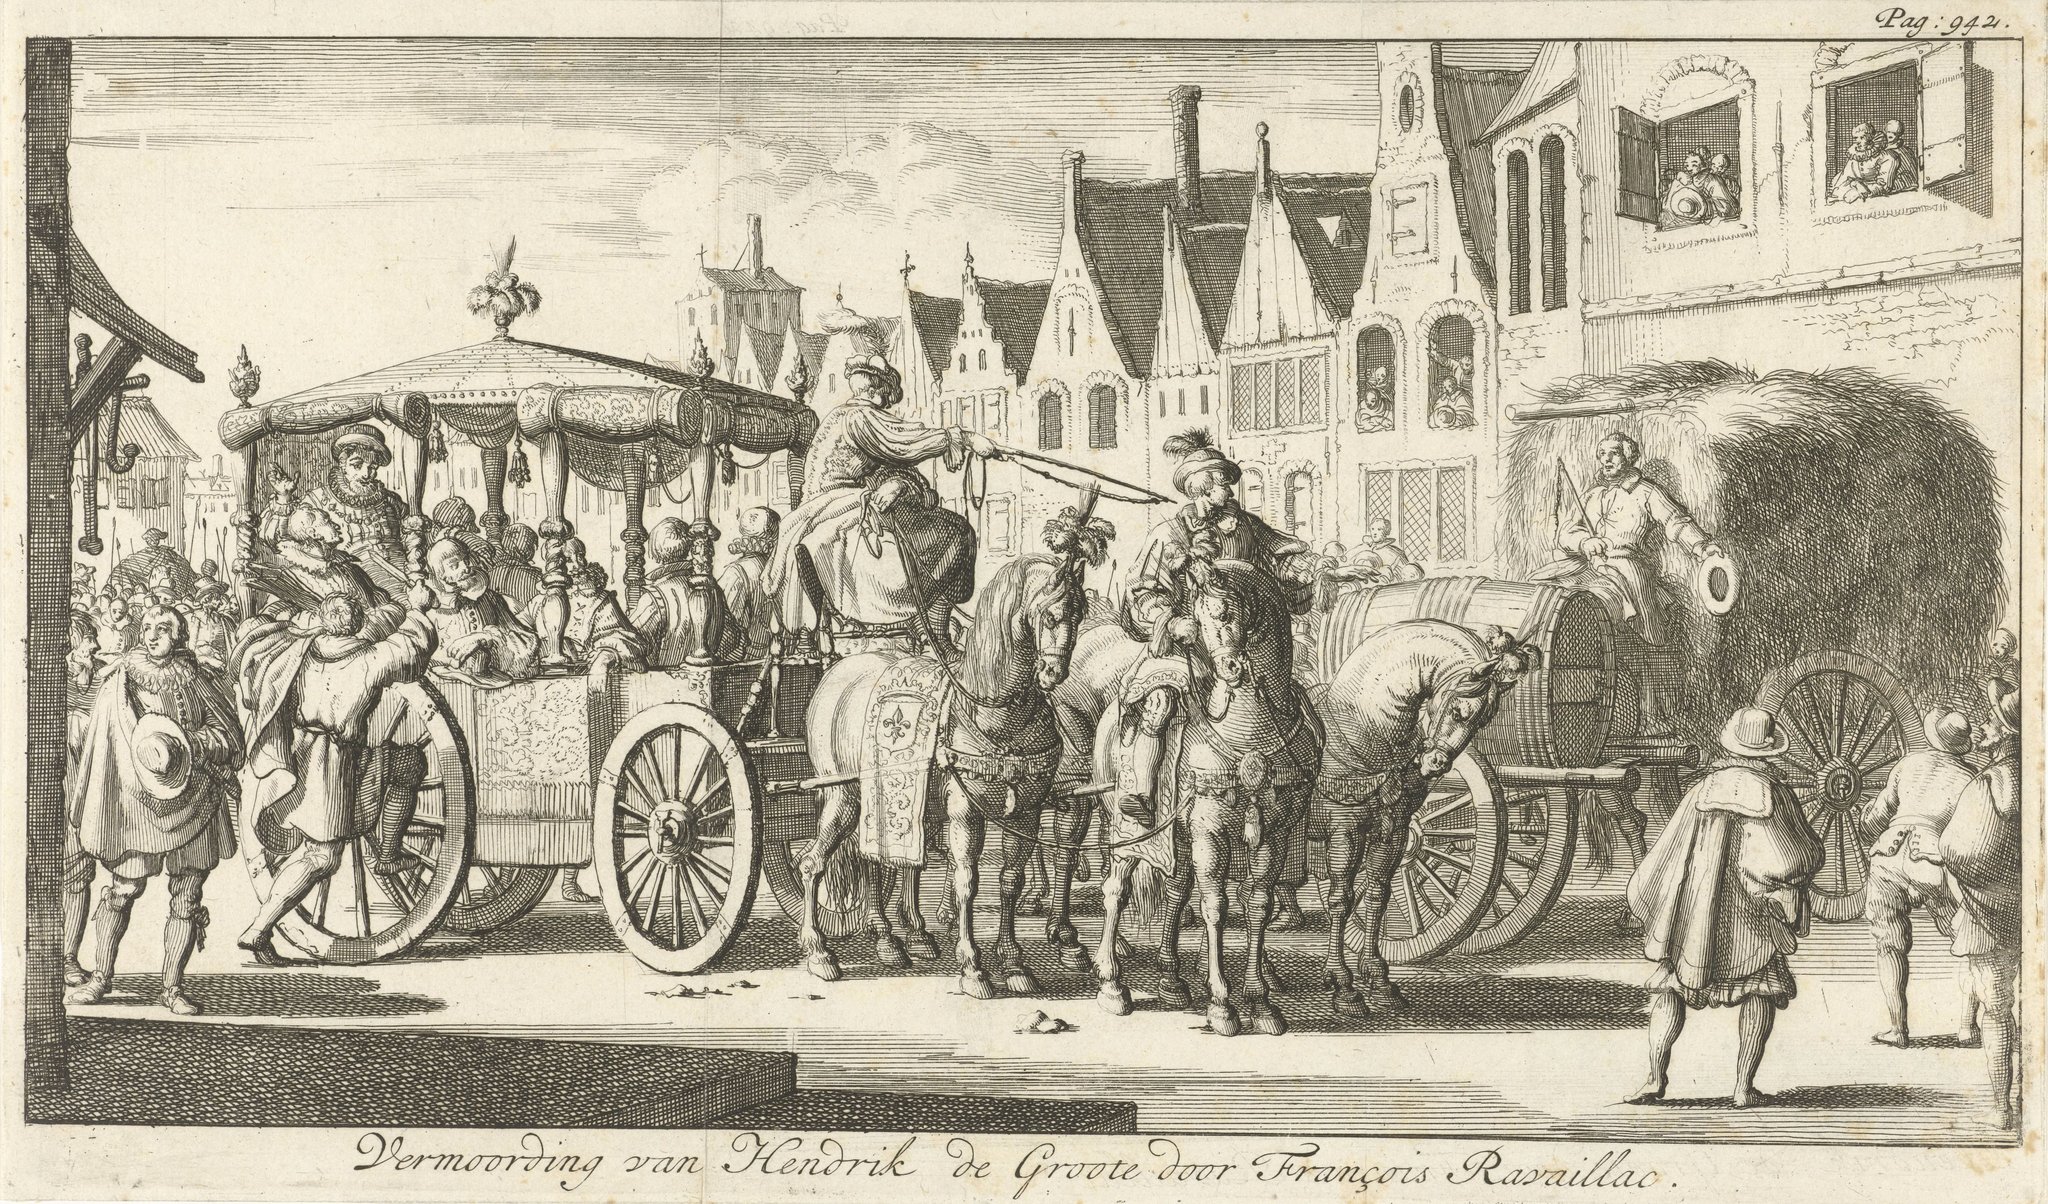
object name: print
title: Vermoording van Hendrik de Groote door François Ravaillac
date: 1685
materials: paper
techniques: etching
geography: amsterdam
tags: paris, hendrik iv (koning van frankrijk en navarra), attempt, political murder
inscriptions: collector's mark: Lugt 2228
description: Moord op de Franse koning Hendrik IV. De koning zittend in een rijtuig wordt vermoord door de monnik François Ravaillac, 14 mei 1610. Prent rechtsboven gemerkt: Pag: 942.